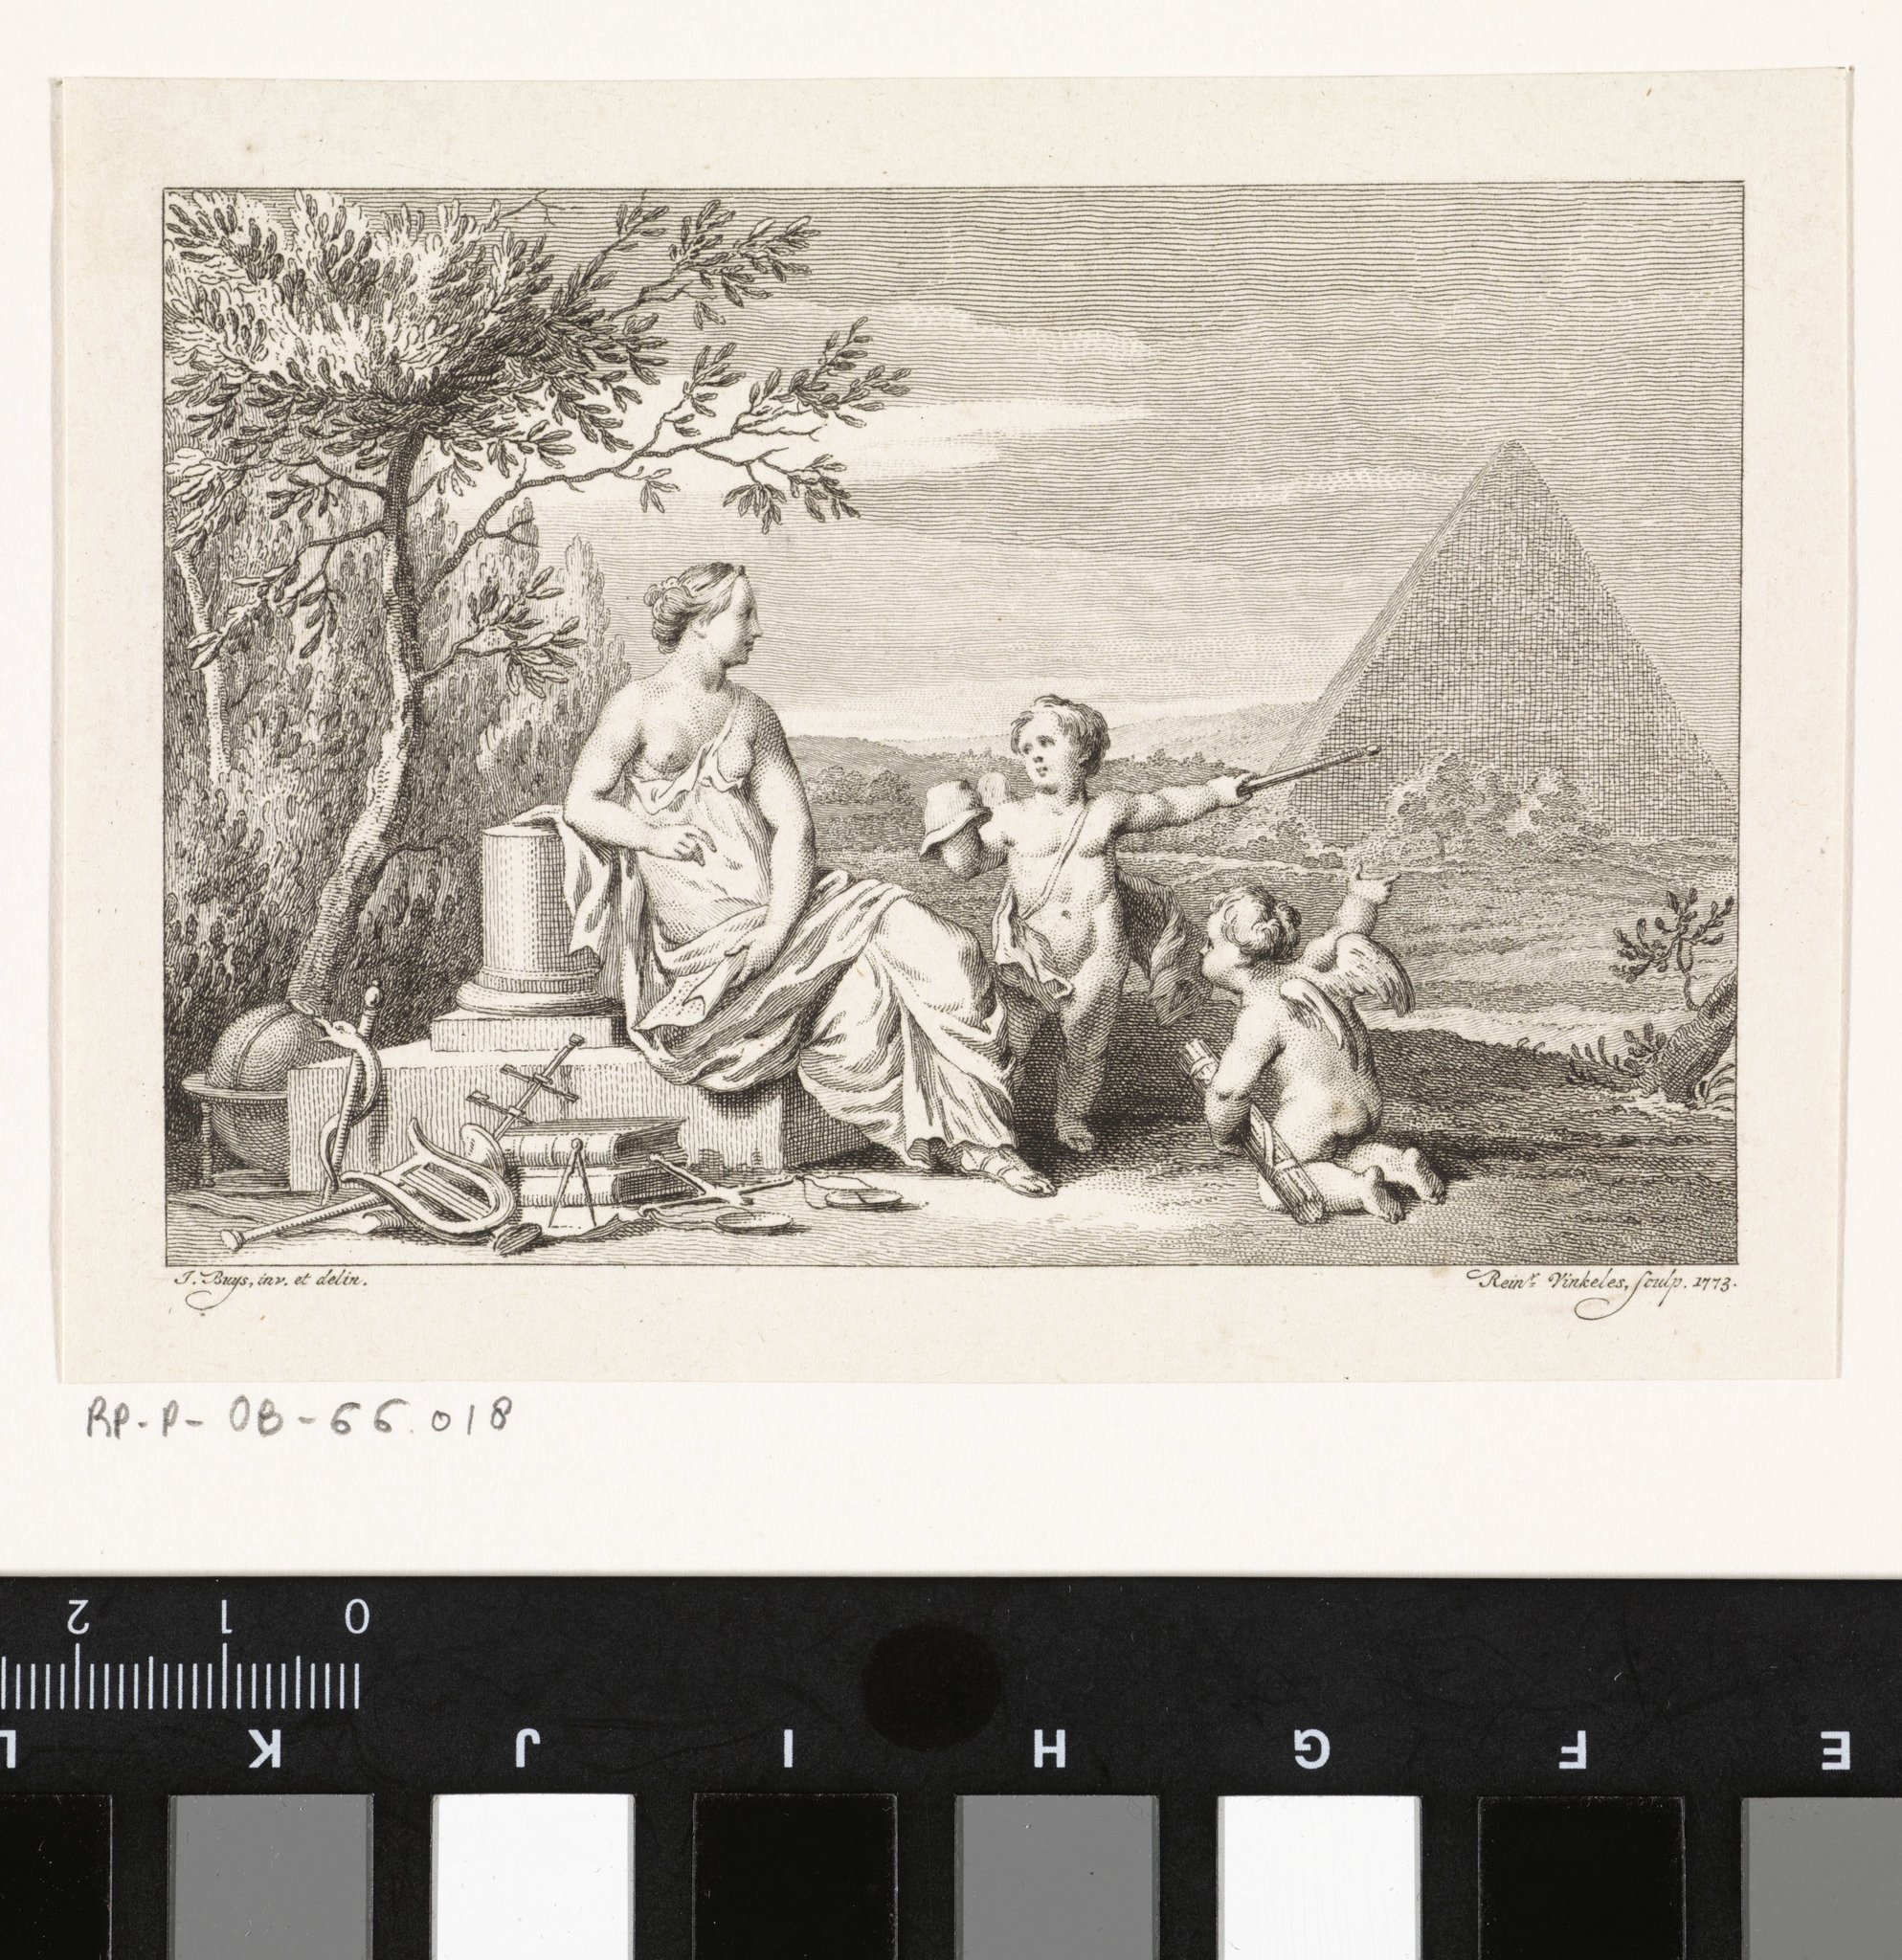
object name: print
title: Twee putti en een jonge vrouw bij een piramide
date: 1773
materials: paper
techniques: engraving, etching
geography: amsterdam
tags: scales, compasses, egyptian pyramids (wonder of the world), cupids: 'amores', 'amoretti', 'putti'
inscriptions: collector's mark: Lugt 240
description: Een jonge vrouw en twee putti met op de achtergrond een piramide. Op de voorgrond liggen attributen met een symbolische betekenis, zoals de weegschaal en de passer.